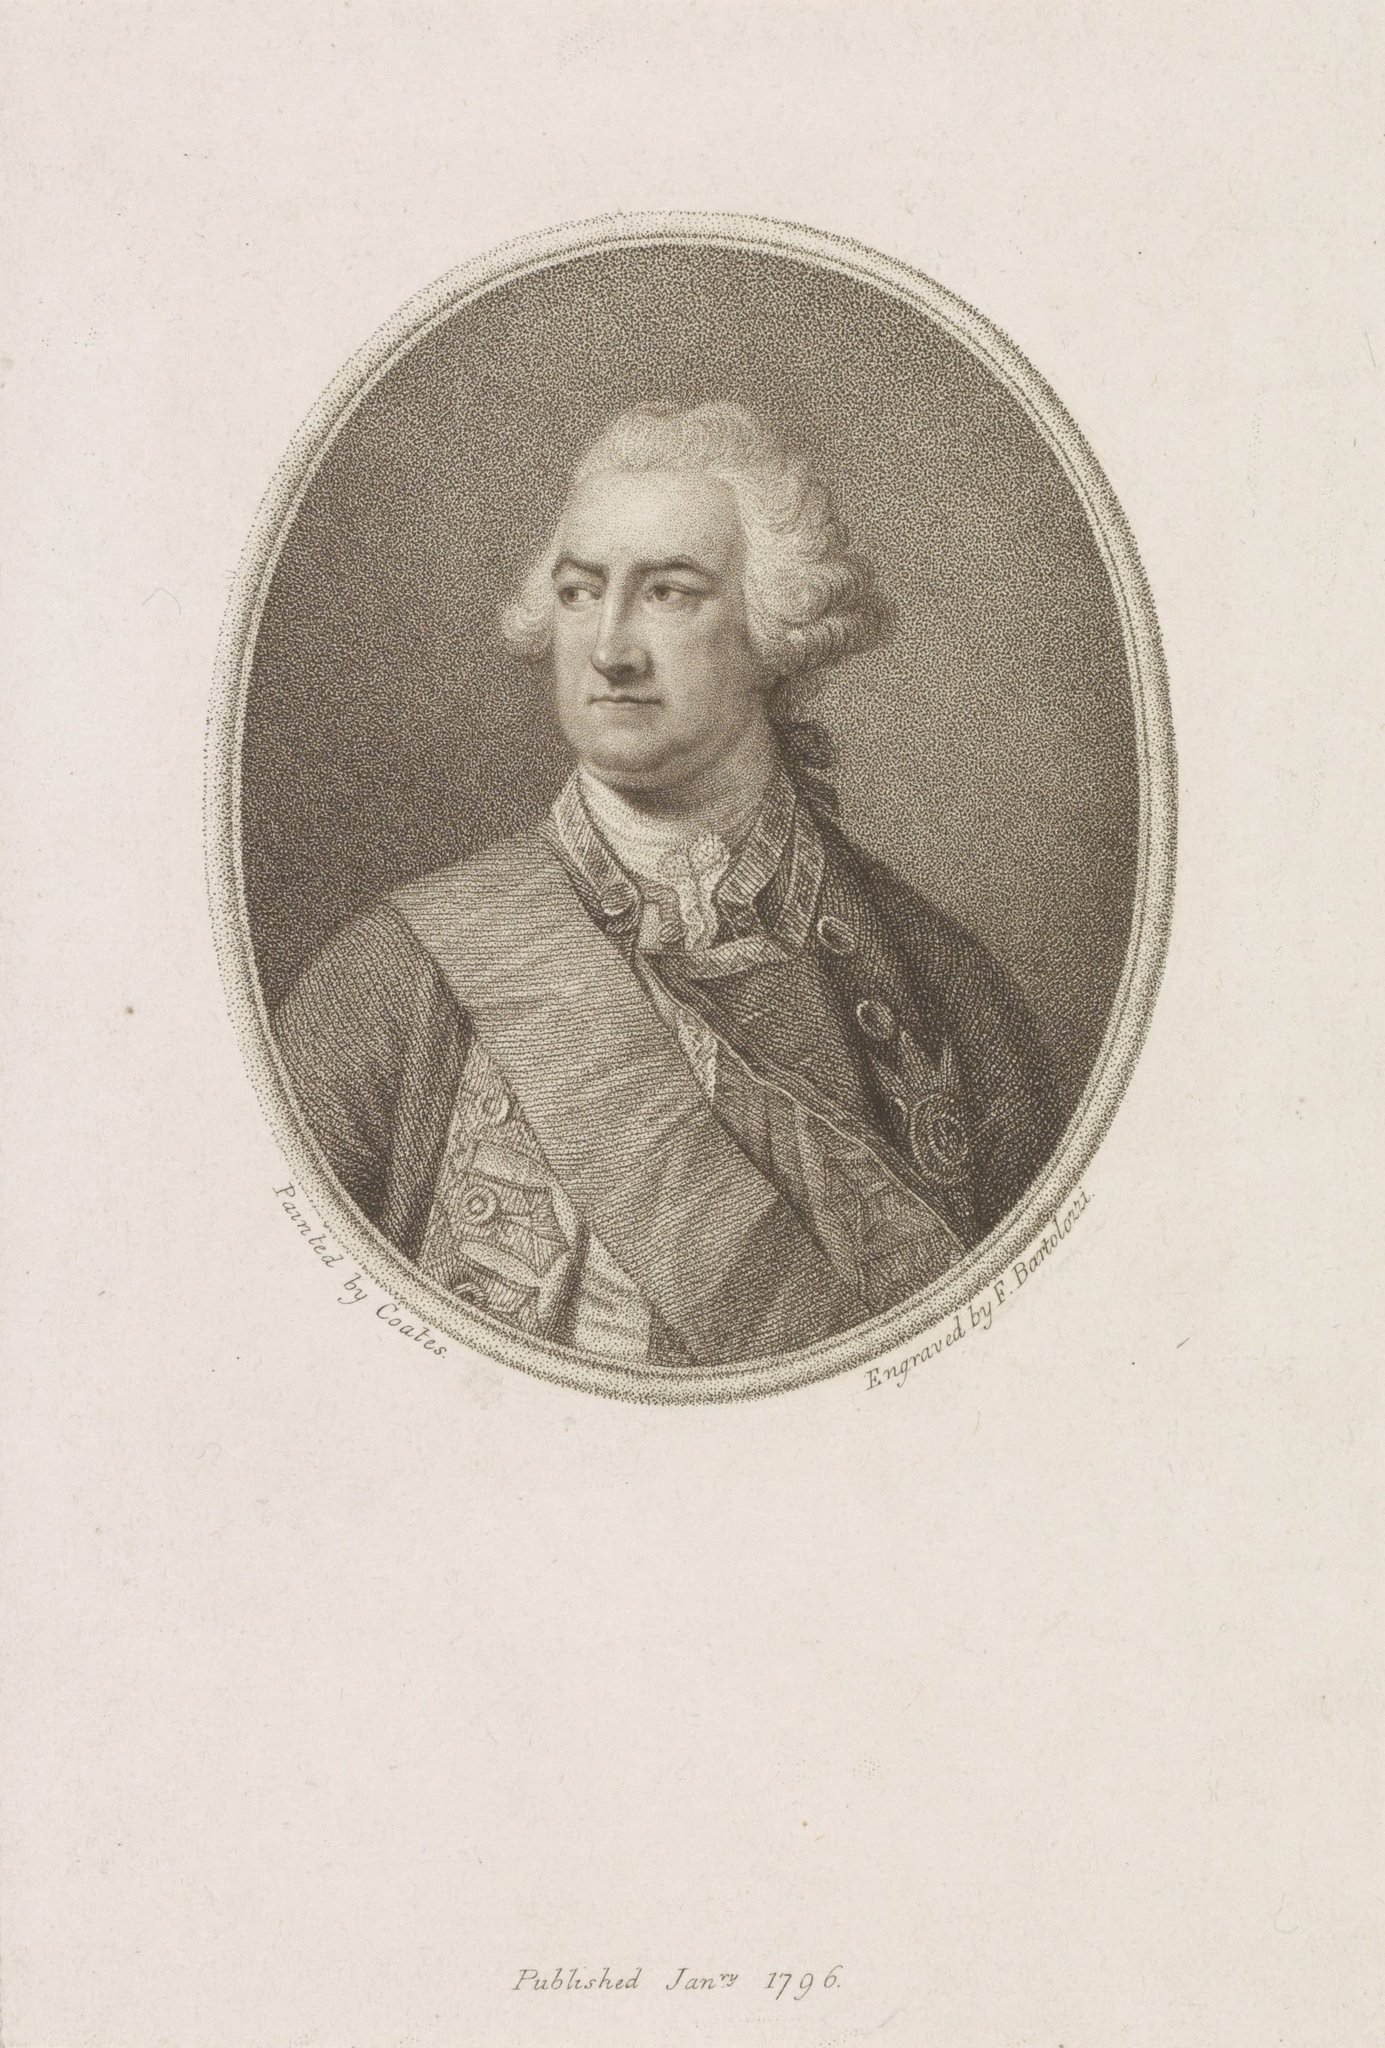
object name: print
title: Portret van Lord Hawke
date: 1701-1796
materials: paper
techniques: etching, engraving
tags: historical persons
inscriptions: collector's mark: Lugt 2228